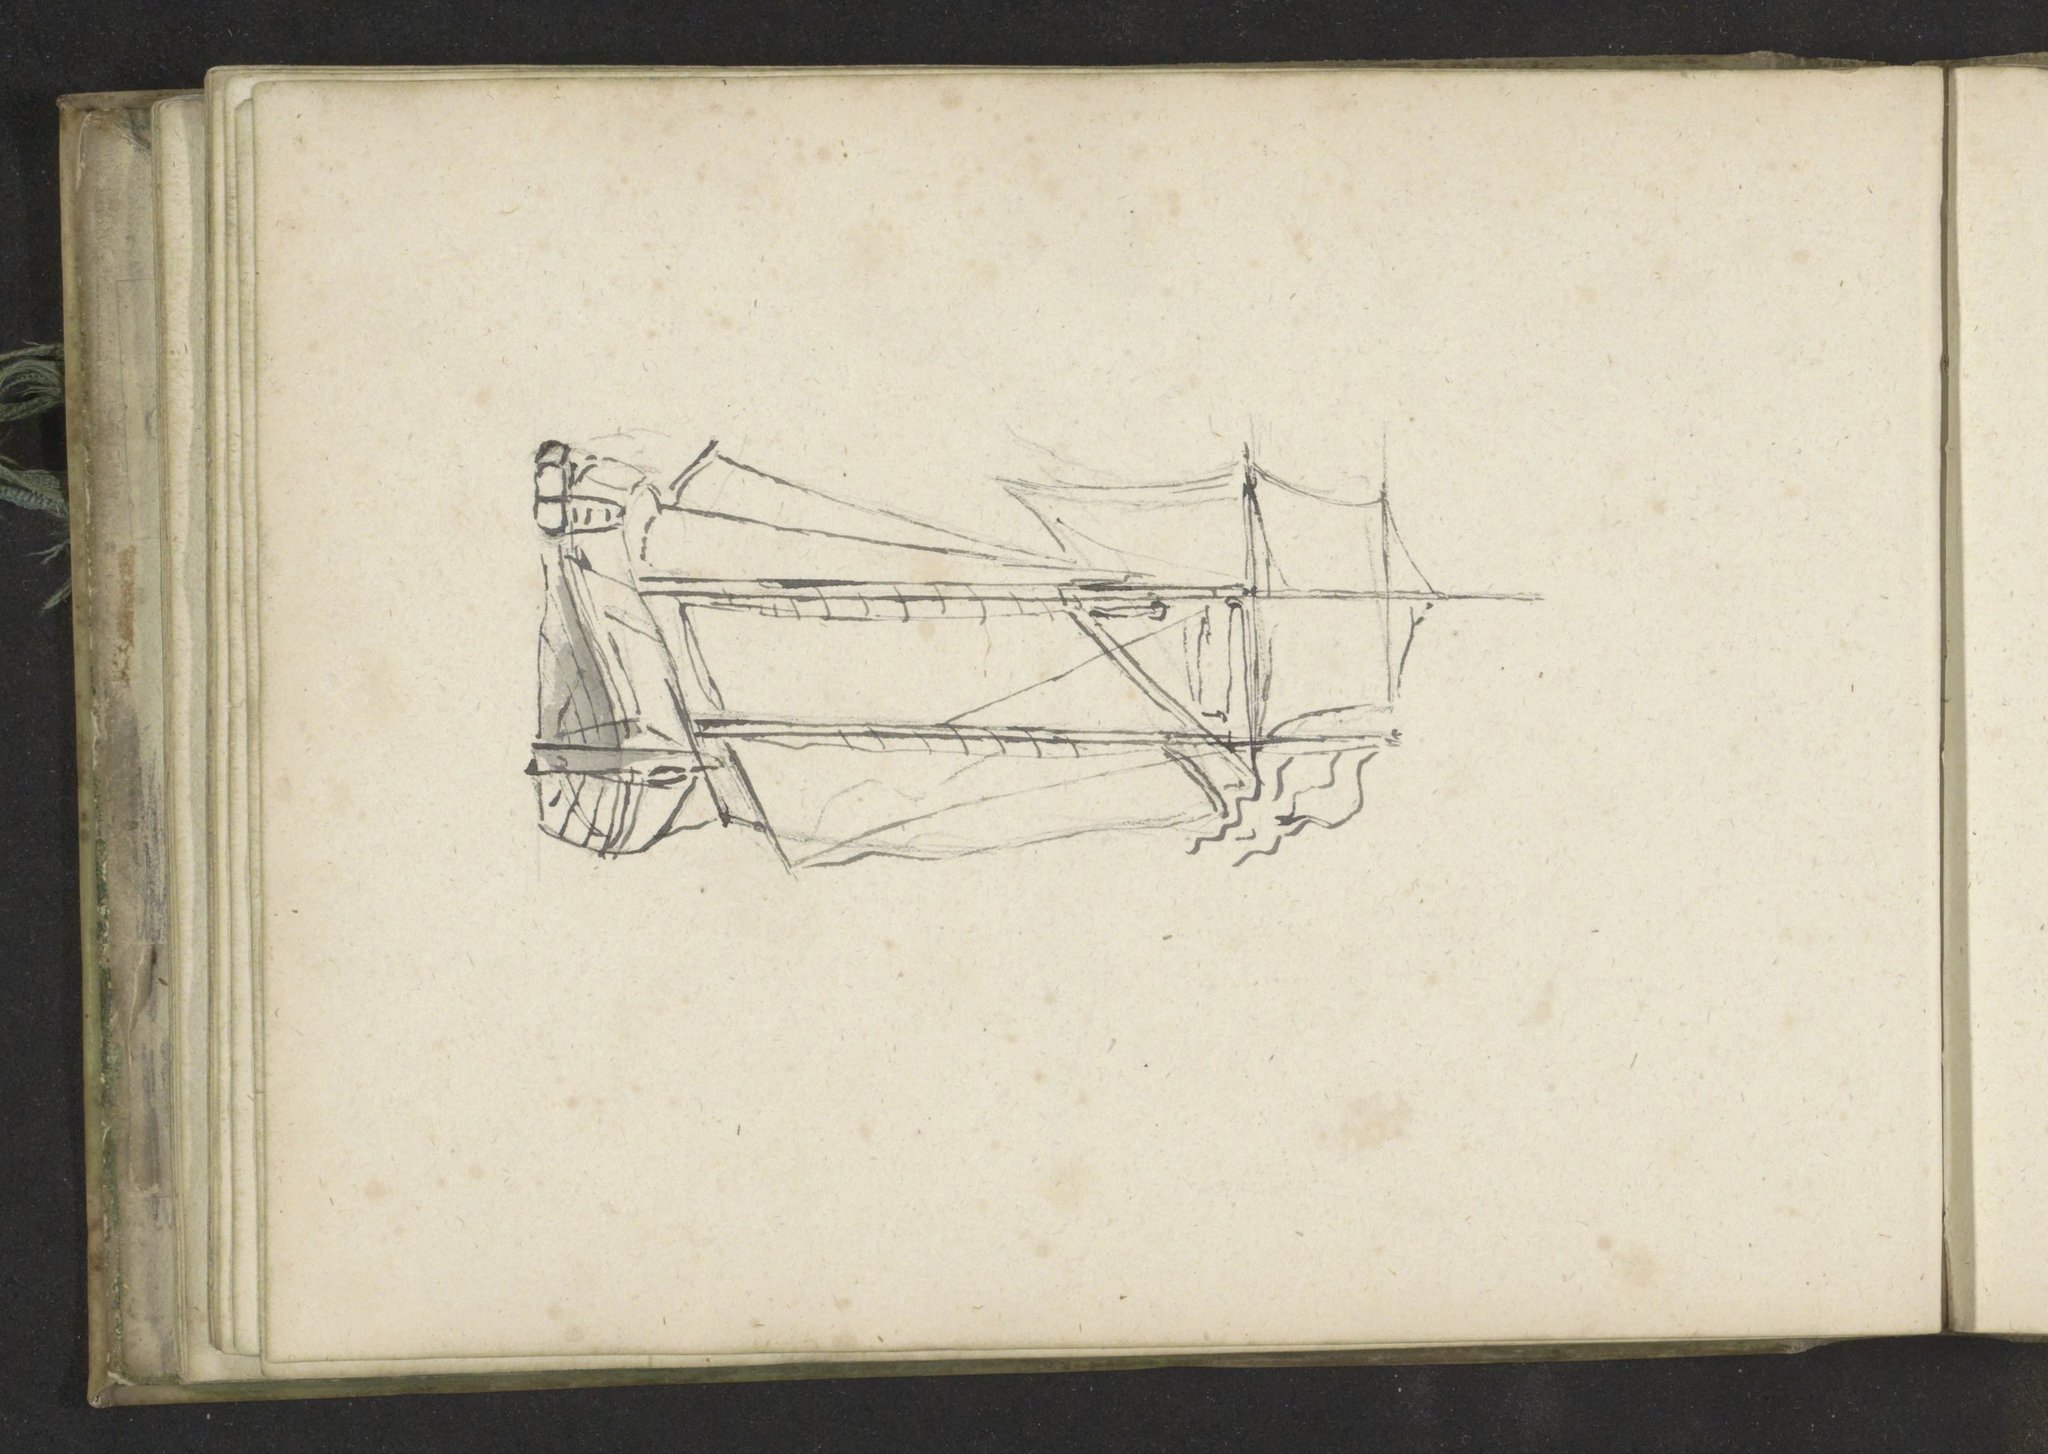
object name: sketchbook leaf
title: Zeilschip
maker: martinus schouman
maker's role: draughtsman, painter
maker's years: 1770-1848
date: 1780-1848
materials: ink, paper, pencil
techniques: brush, pen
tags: sailing-ship, sailing-boat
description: Blad 23 verso uit een schetsboek met 53 bladen.